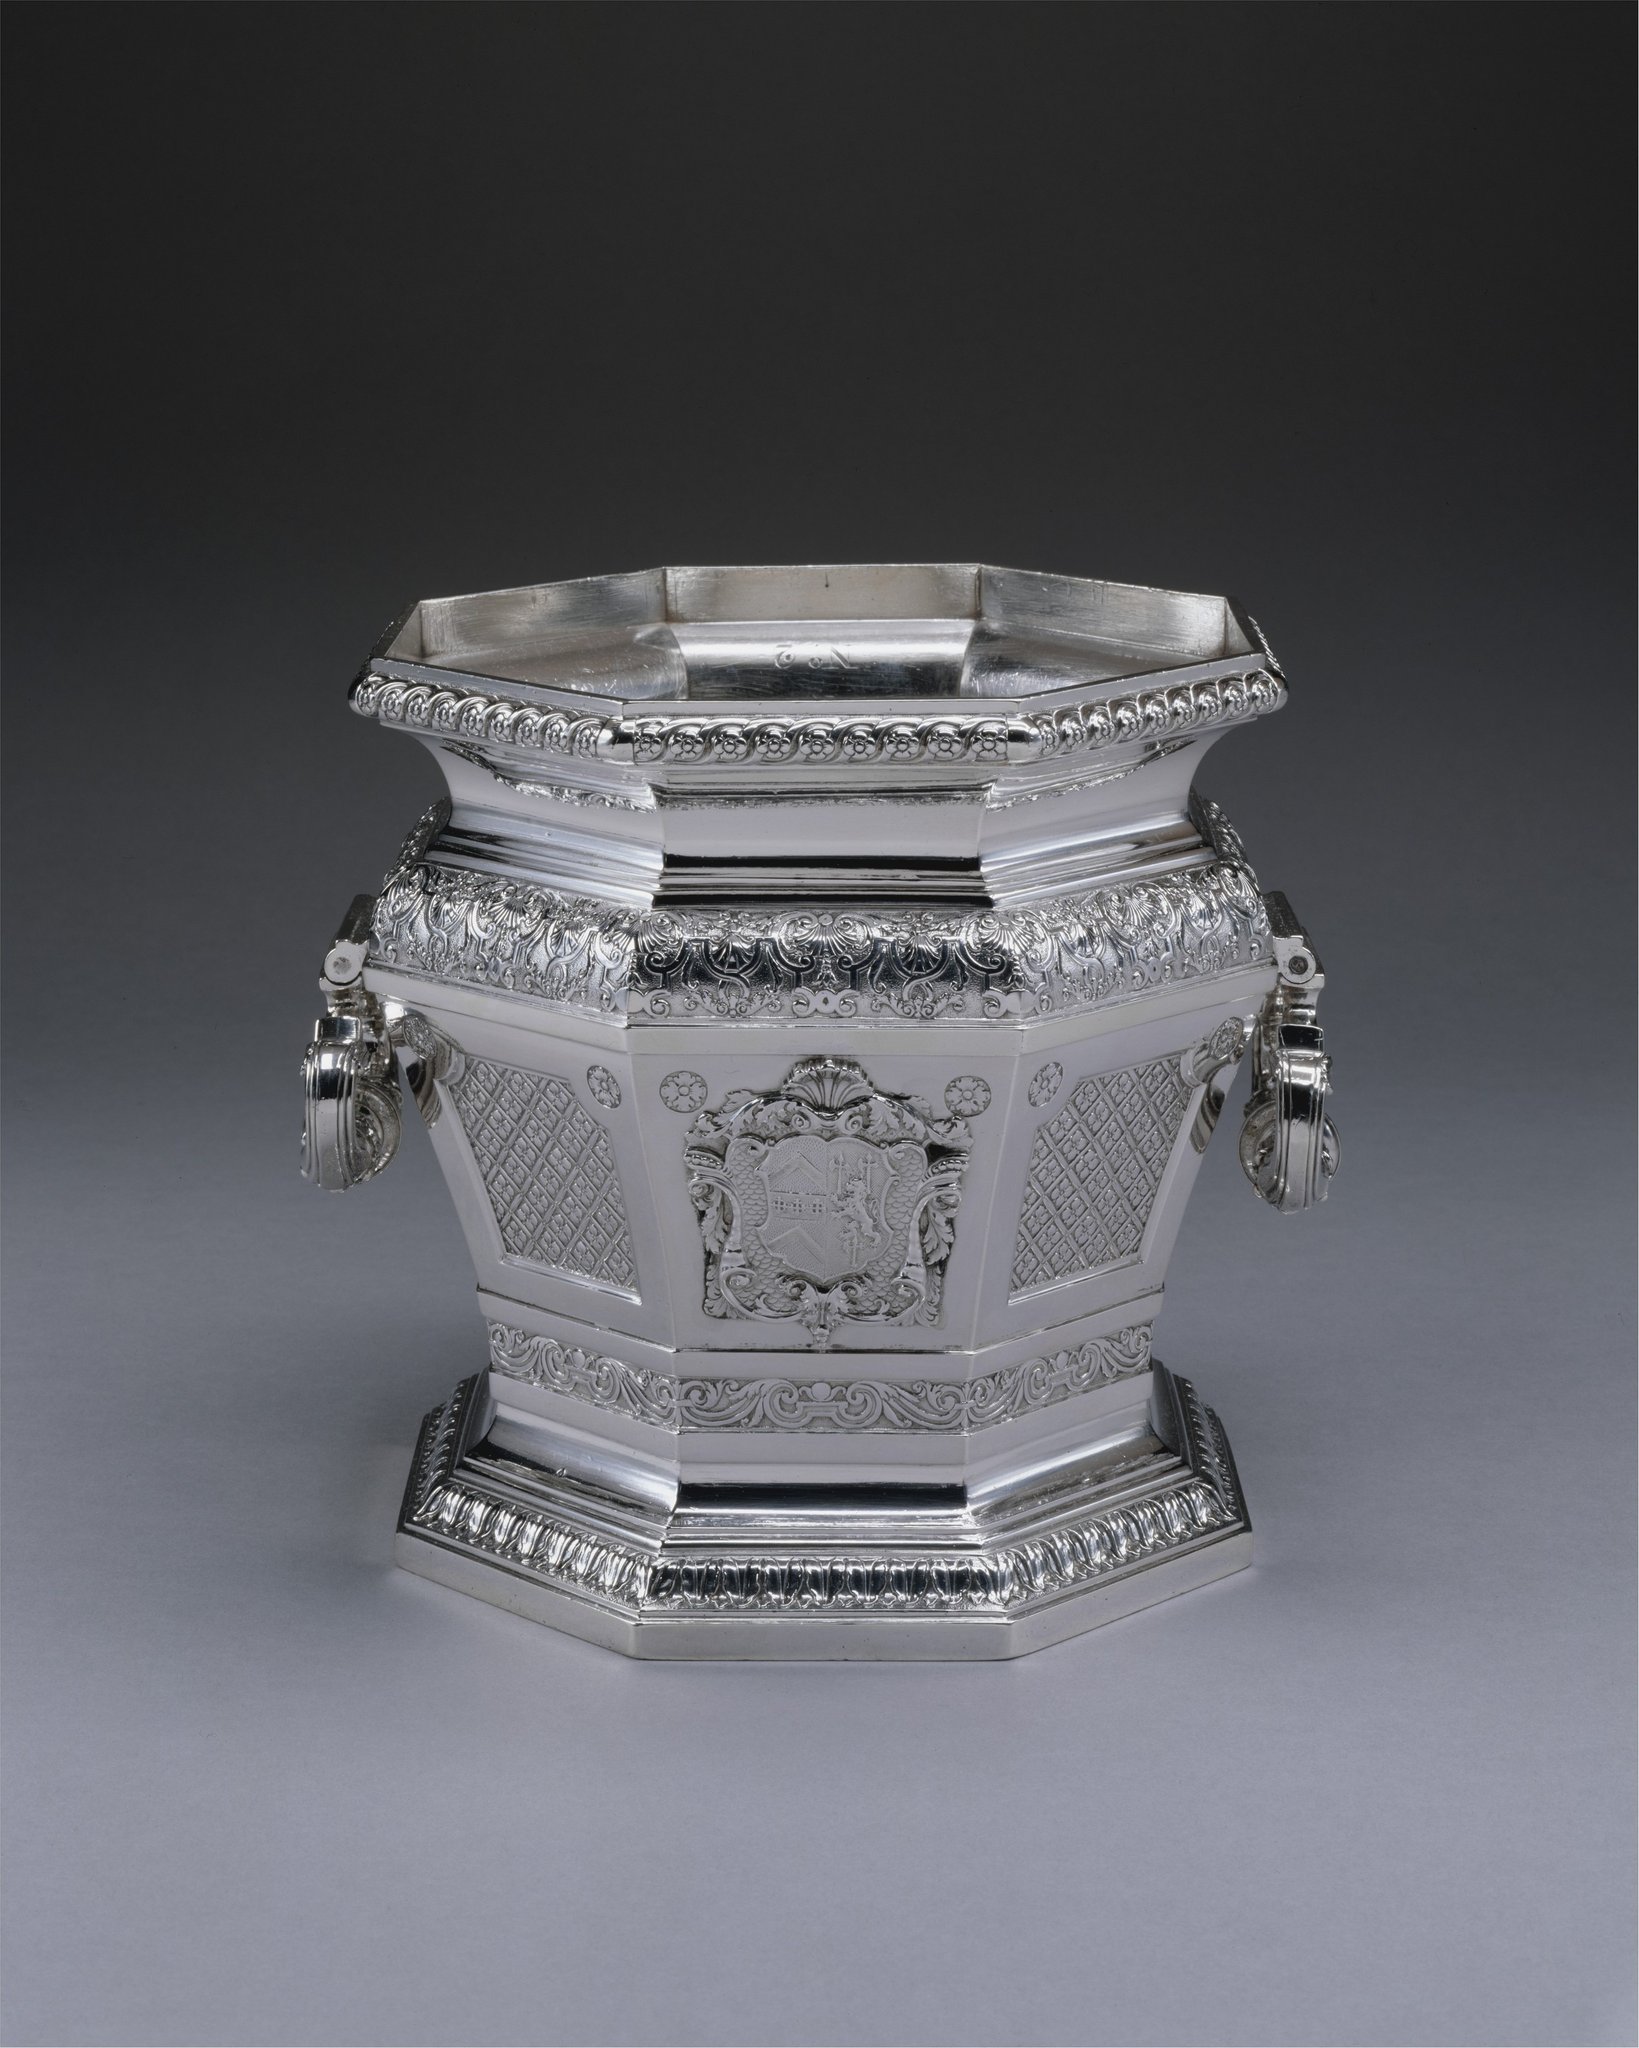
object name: wine cooler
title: Wine cooler (one of a pair)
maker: william lukin i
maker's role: maker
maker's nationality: british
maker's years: 1699-1755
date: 1716-1717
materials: silver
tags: coat of arms